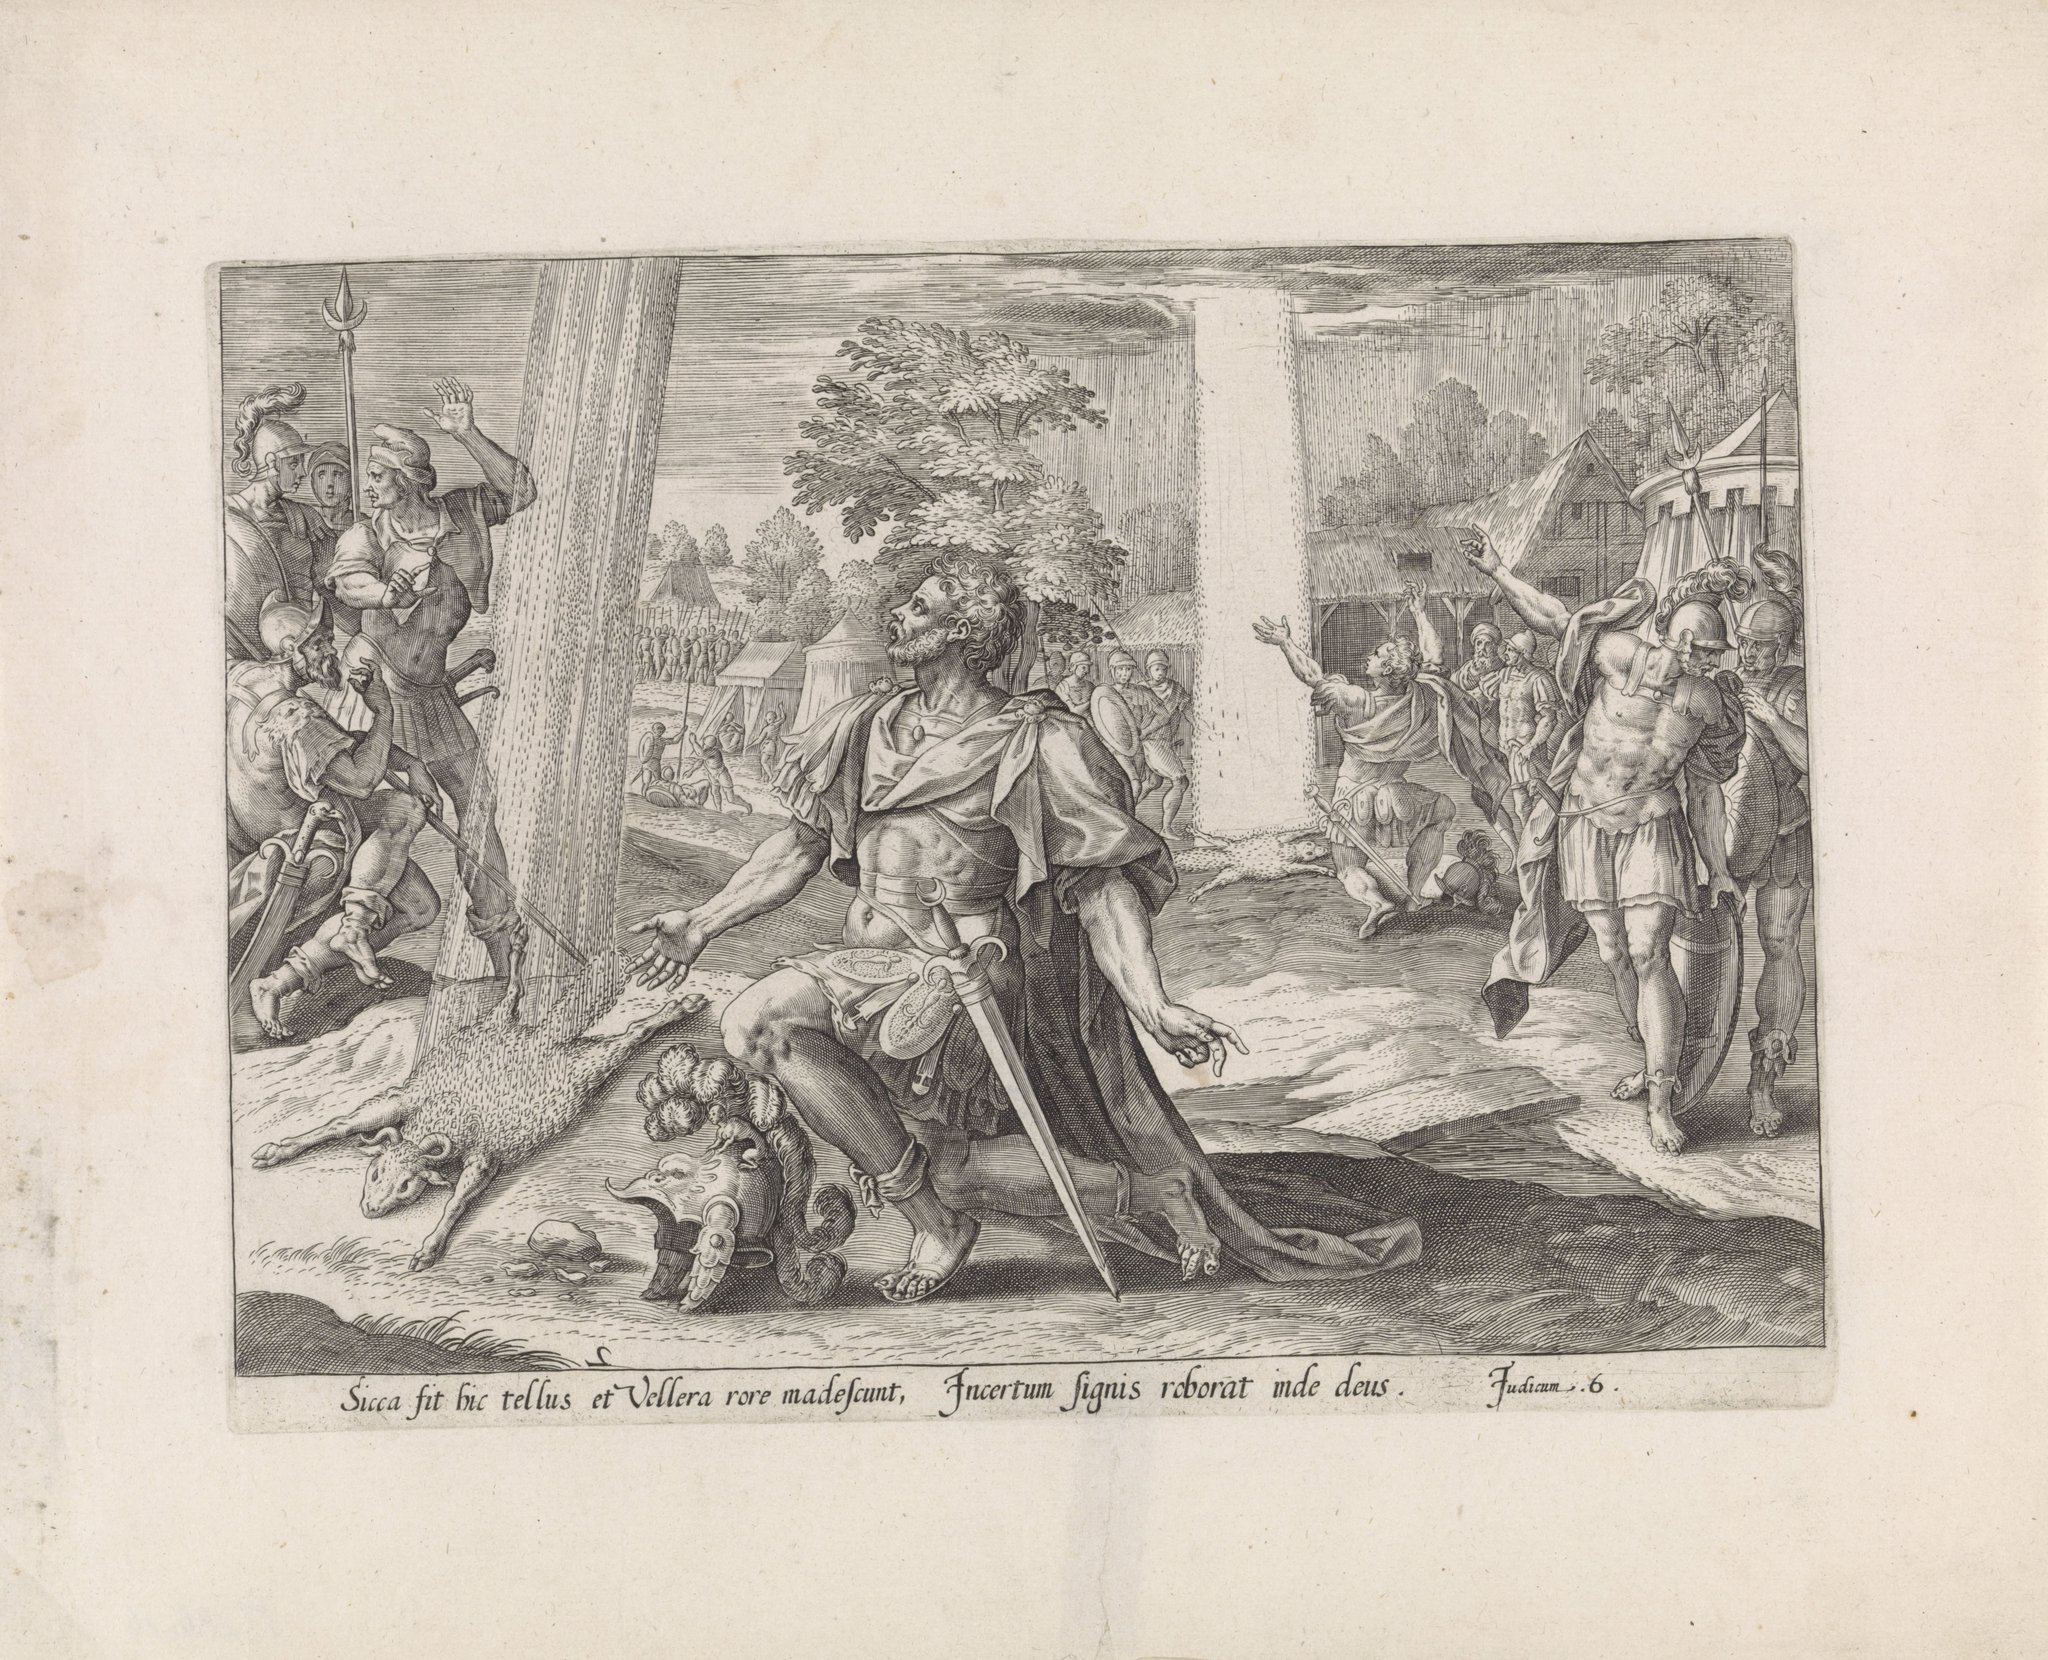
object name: print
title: Gideon en de schapenvacht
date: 1585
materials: paper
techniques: engraving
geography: antwerp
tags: twice gideon asks the lord to show him a sign with a sheep's fleece before his raid against the midianites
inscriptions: collector's mark: Lugt 2228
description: Gideon knielt neer bij de schaapsvacht. De dauw valt alleen op de schaapsvacht. Rechts op de achtergrond knielt Gideon voor de tweede maal bij de schaapsvacht. Dit keer valt de dauw alleen rond de schaapsvacht en niet op de schaapsvacht. Gideons mannen kijken verbaasd toe. Onder de voorstelling een verwijzing in het Latijn naar de Bijbeltekst in Ri. 6.